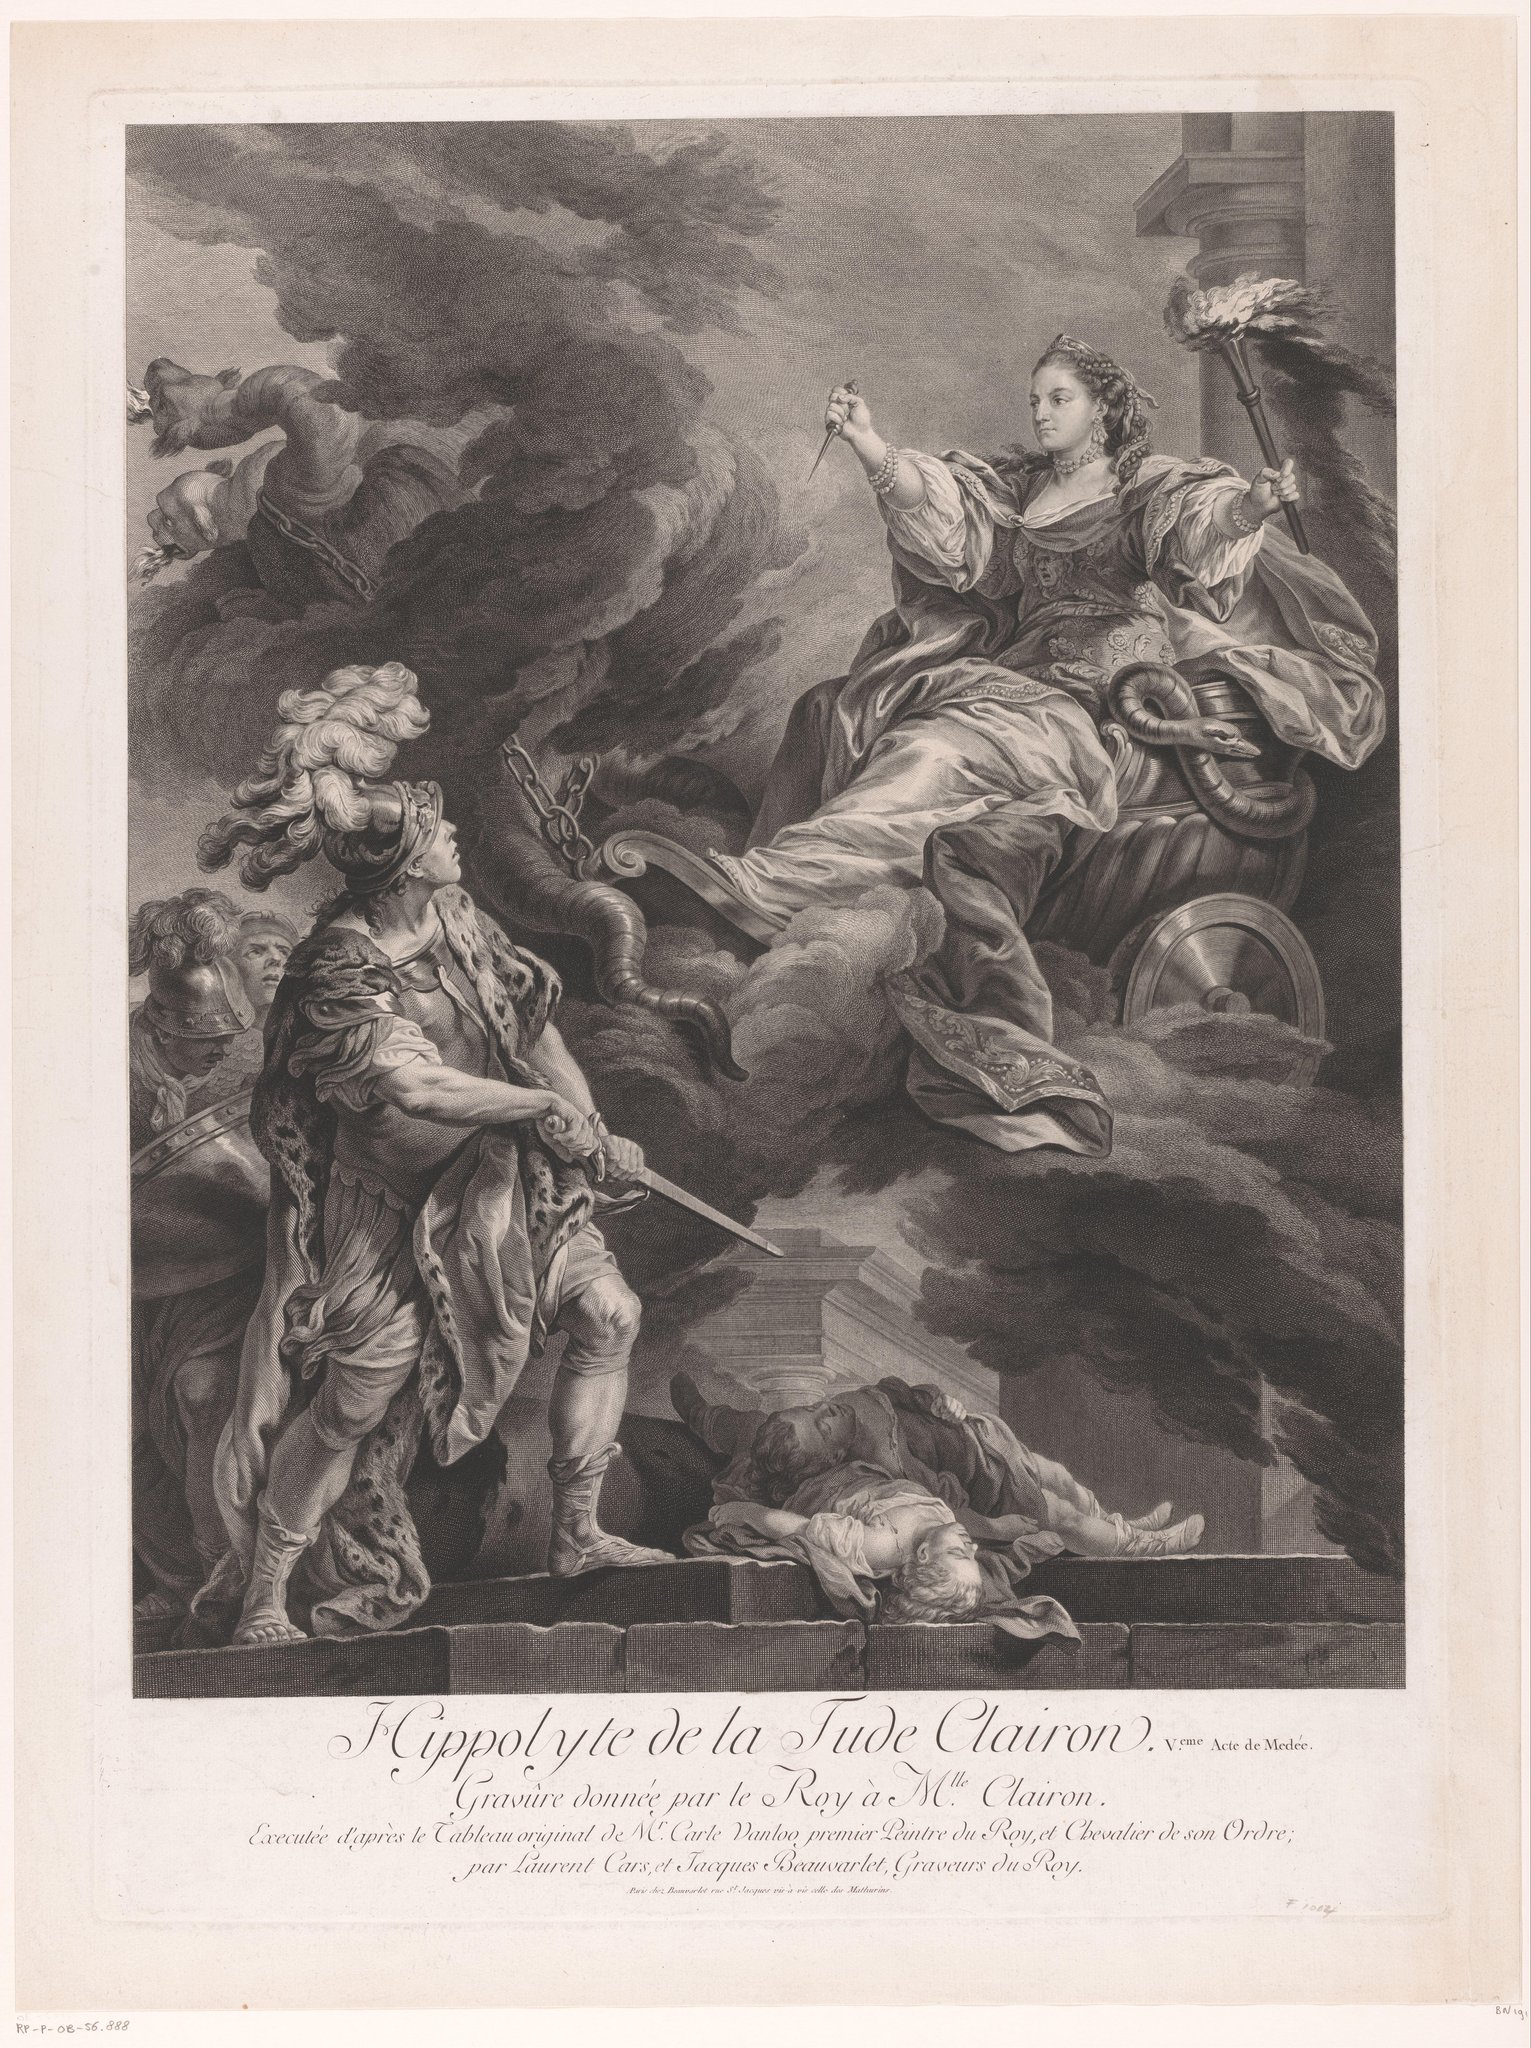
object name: print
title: Portret van Claire Clairon in de rol van Medea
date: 1764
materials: paper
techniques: engraving, etching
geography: paris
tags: paris, medea kills her two children; she flees from corinth in a chariot drawn by winged dragons, historical persons, portrait of actor, actress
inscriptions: number: ‘f 2250-’, collector's mark: Lugt 240